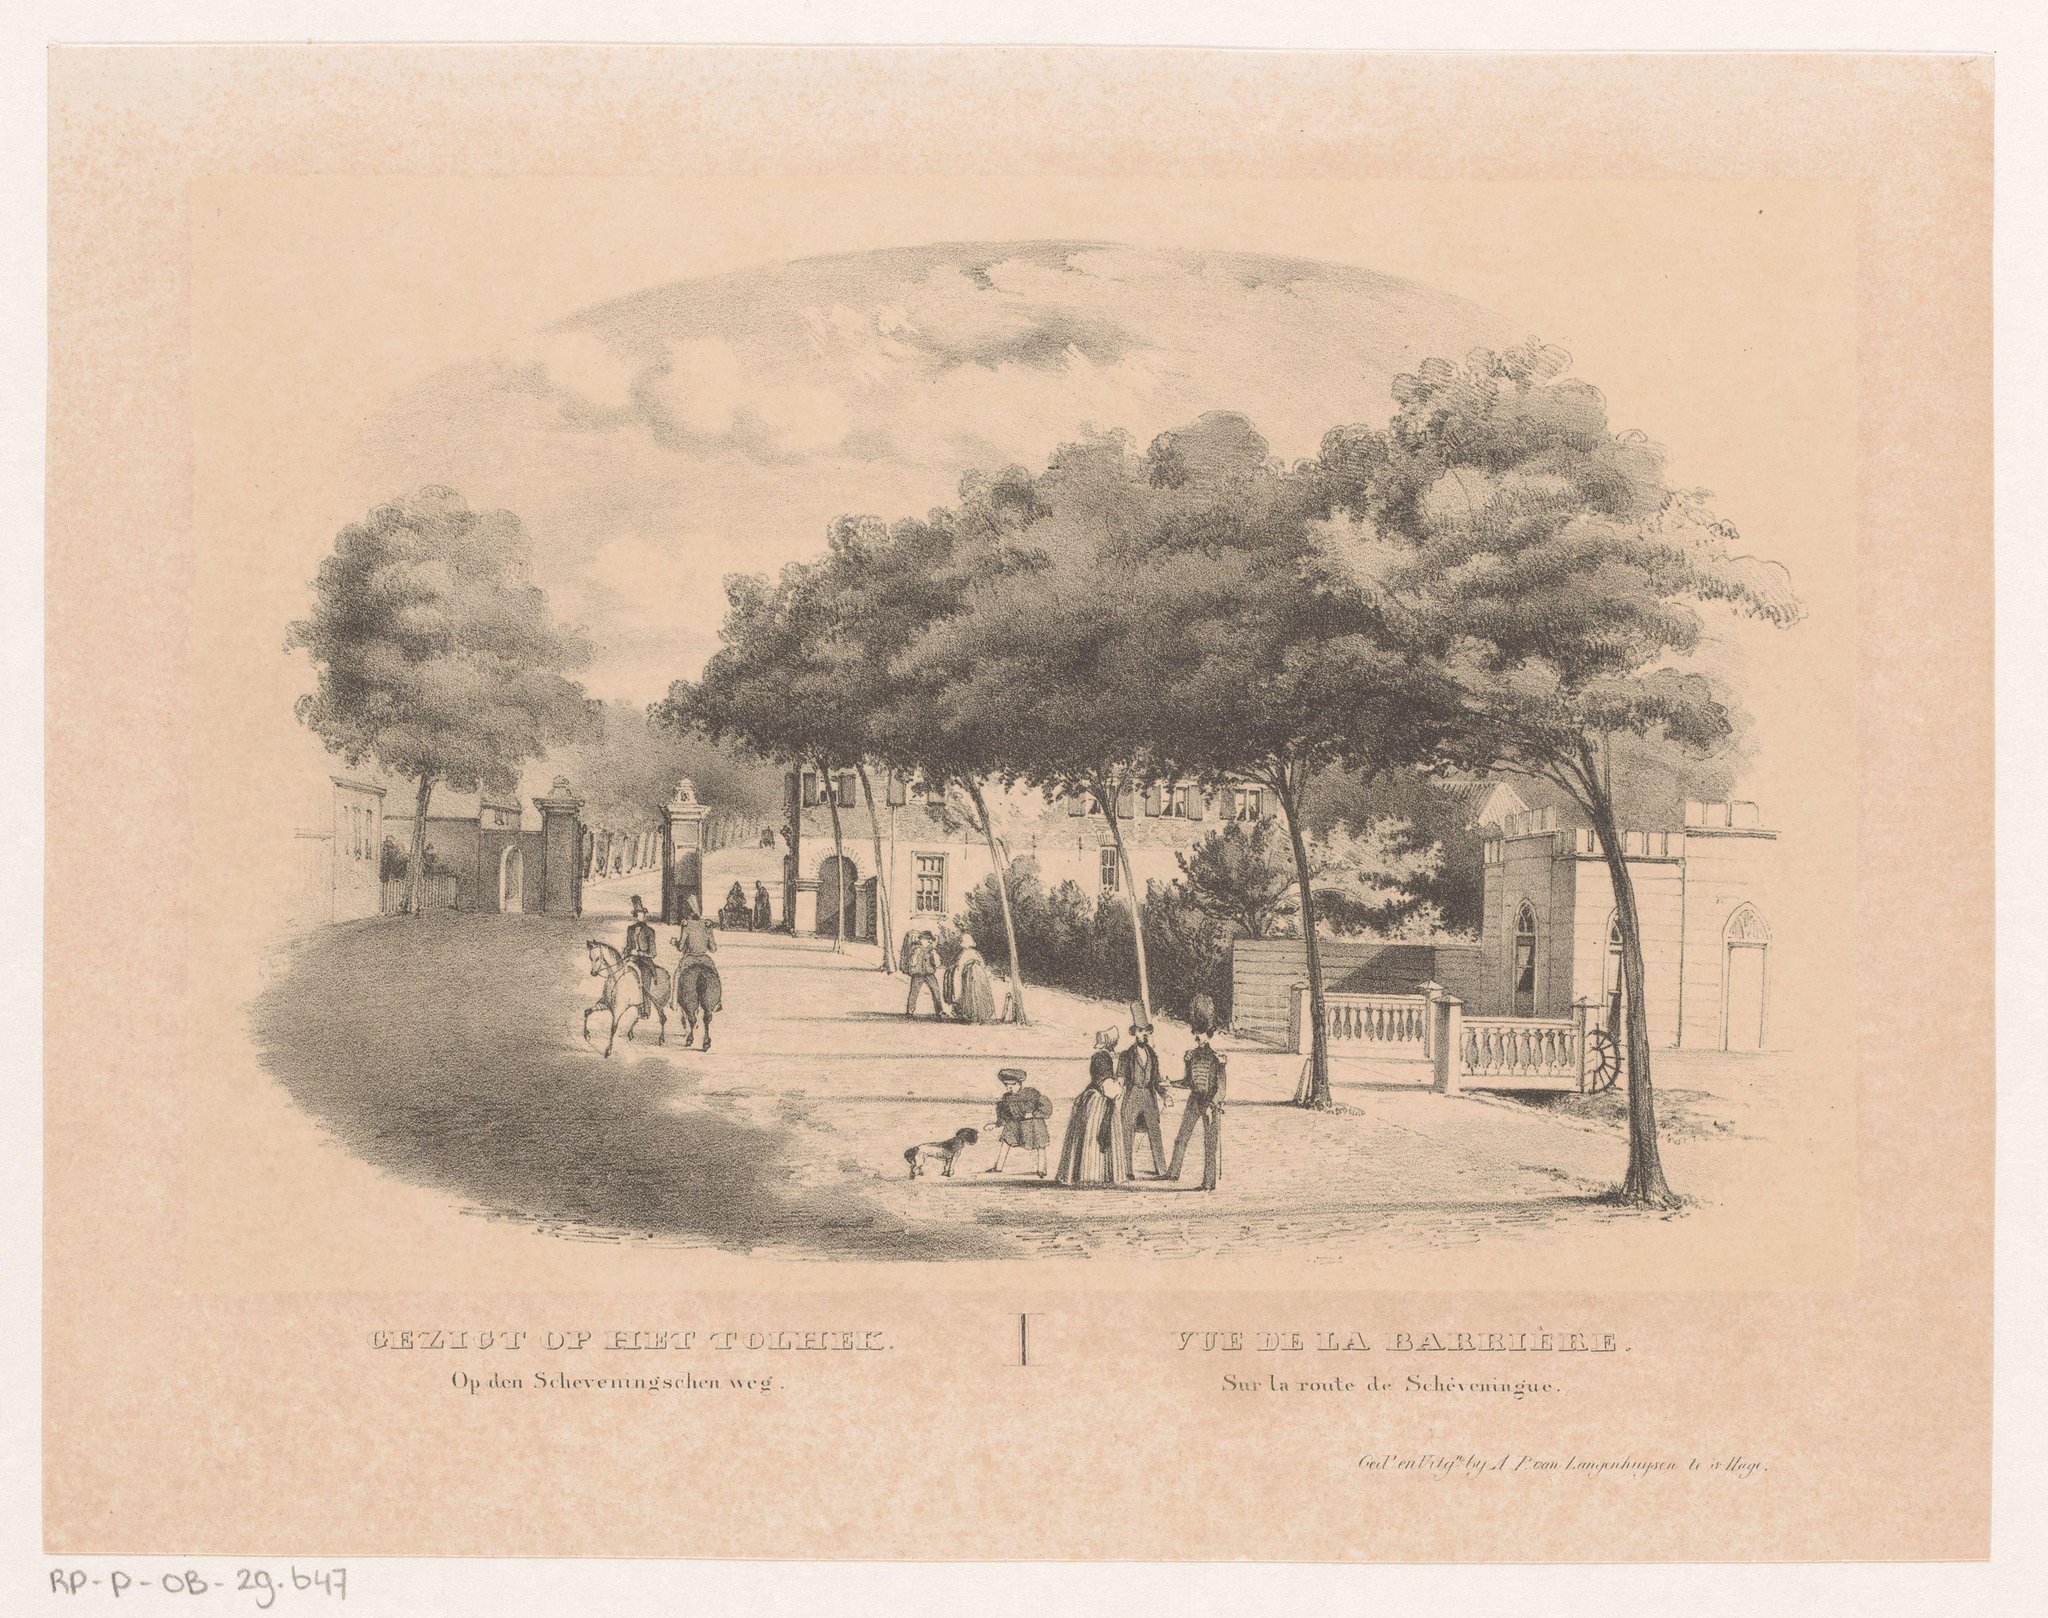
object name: print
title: Huijgenspoort te Den Haag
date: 1830-1846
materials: paper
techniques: tone lithography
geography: the hague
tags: toll gate, the hague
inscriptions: collector's mark: Lugt 2228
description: Mensen in een park met in de achtergrond het tolhek (De Huijgenspoort) en tolgaarderswoning. Het tolhek bevindt zich tegenwoordig aan de Kerkhoflaan als toegang tot de Scheveningse Bosjes.